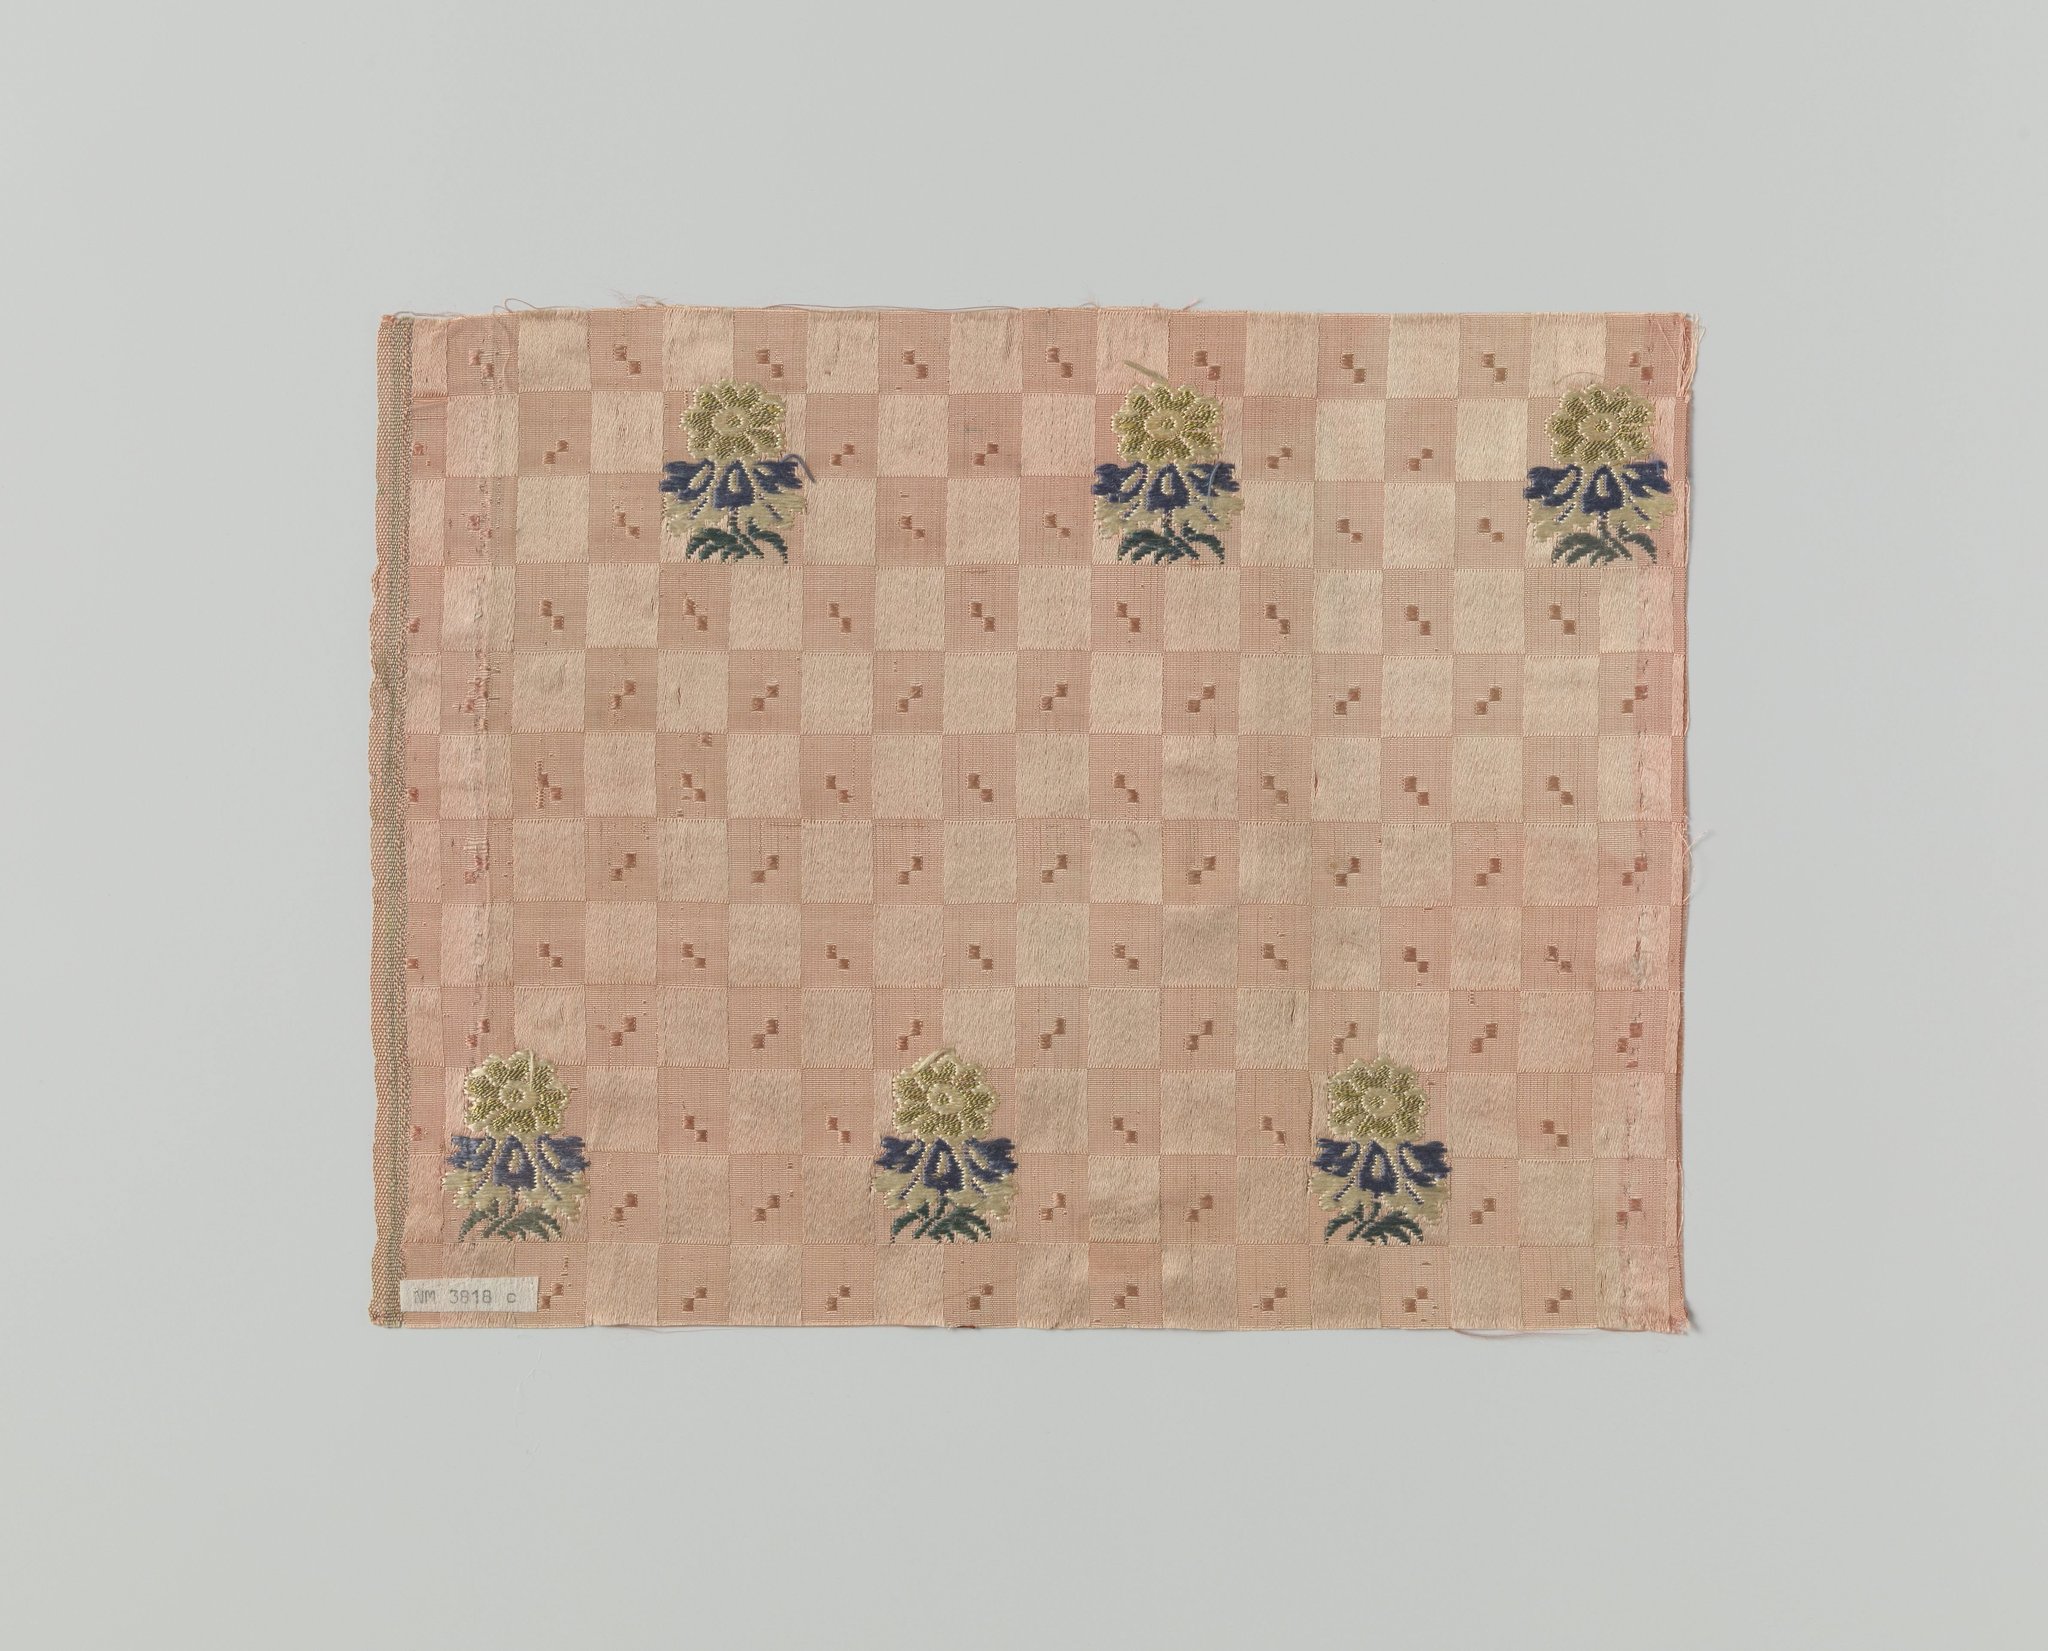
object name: zijdedamast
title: Fragment roze geblokt zijdedamast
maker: Anonymous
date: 1750-1800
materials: silk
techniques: brocade, damask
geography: germany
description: Fragment roze geblokt zijdeweefsel met bloemtakken in wit, blauw en groen.